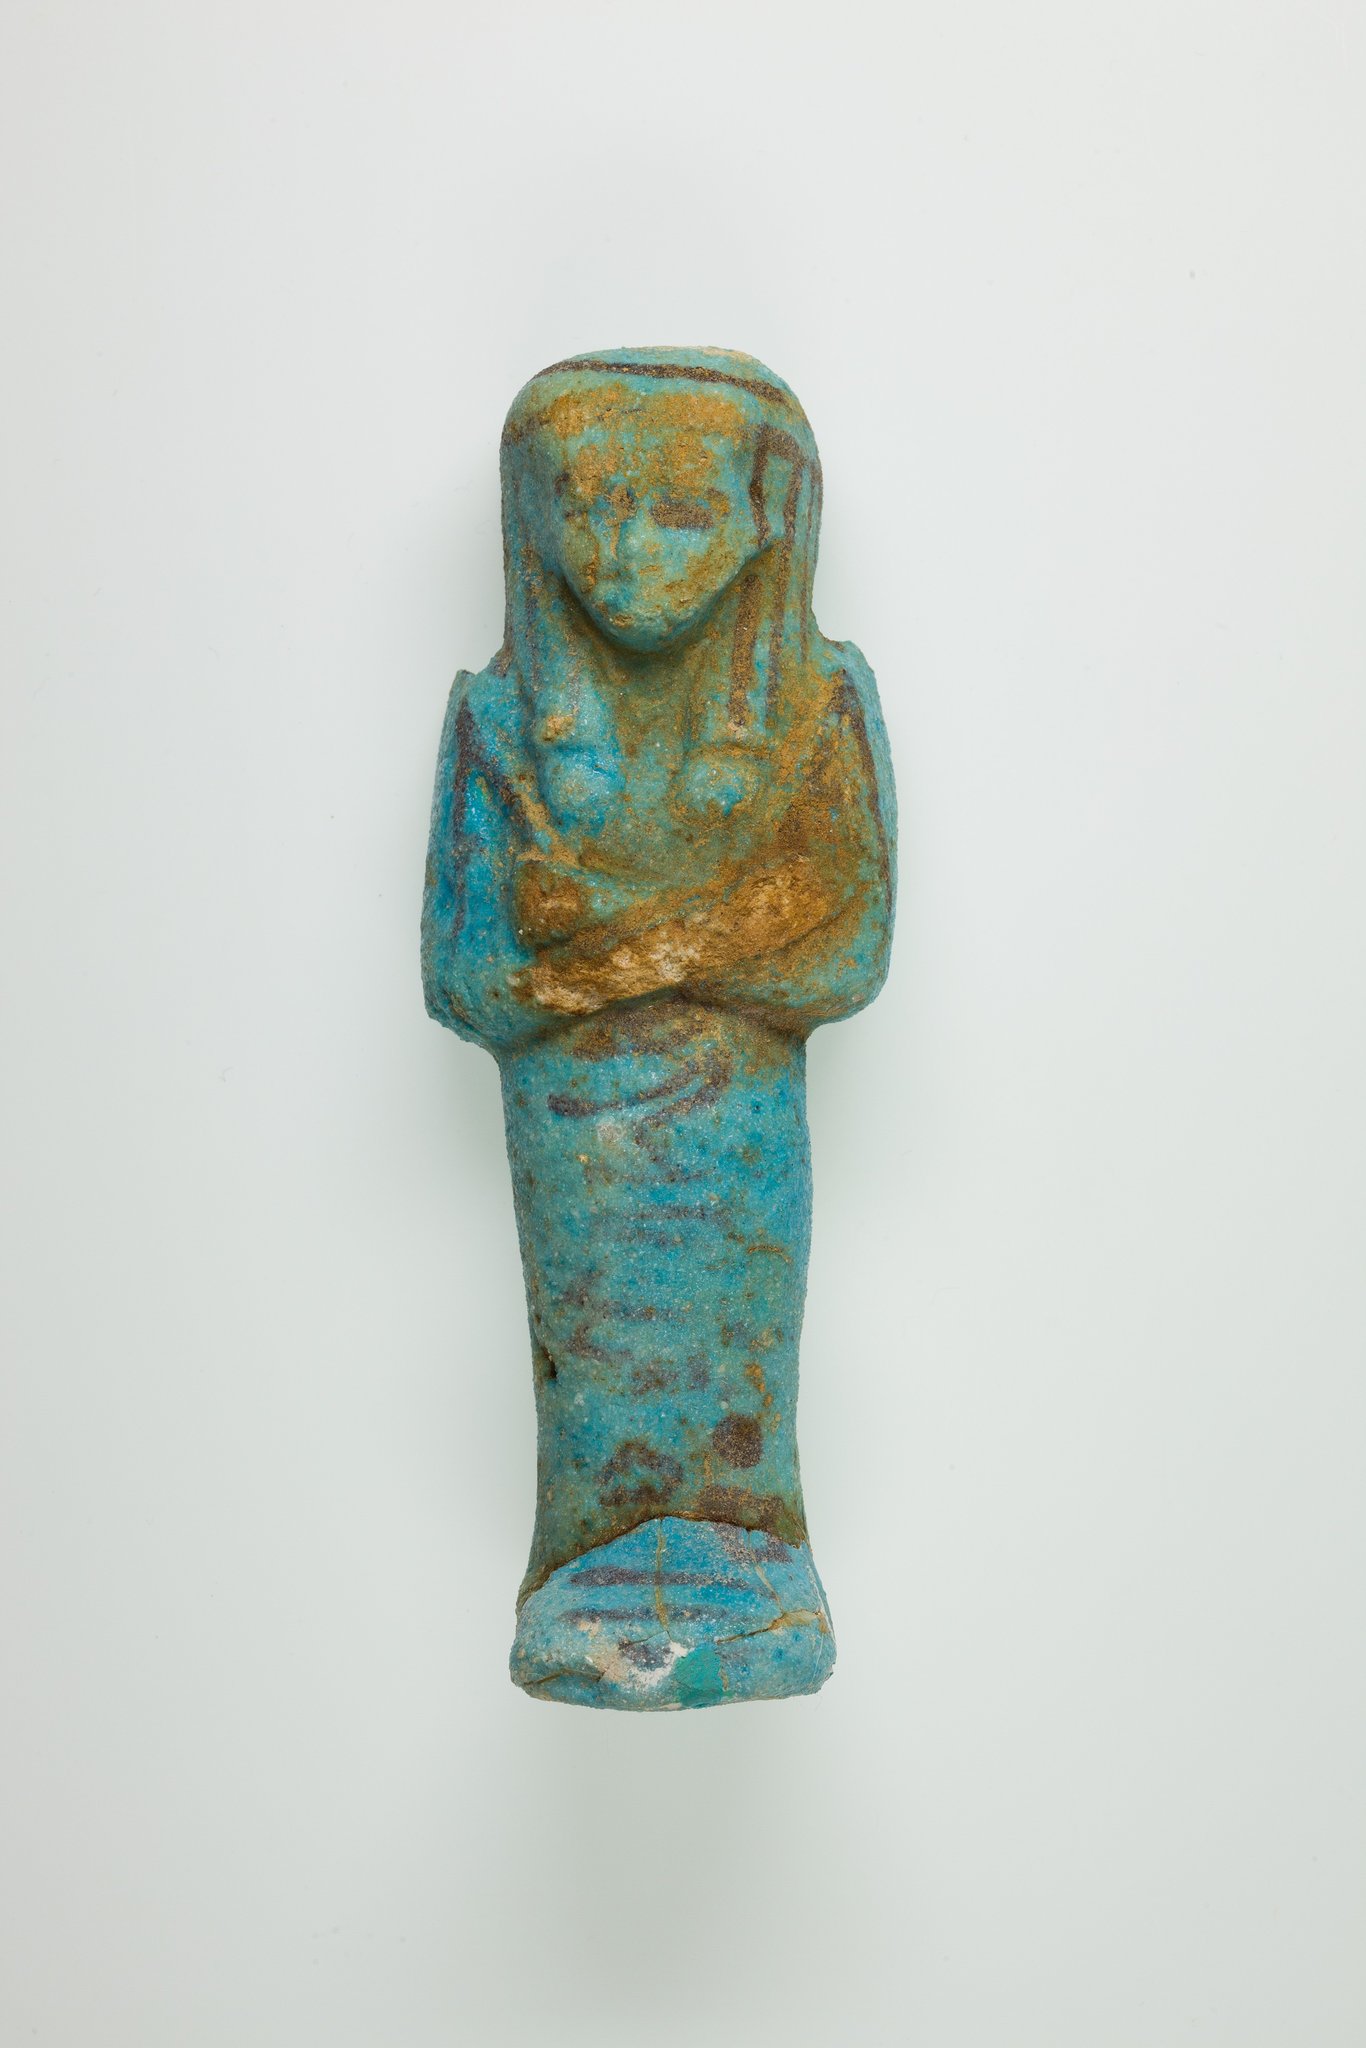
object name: shabti, henettawy c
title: Worker Shabti of Henettawy (C), Daughter of Isetemkheb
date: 990-970 BCE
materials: faience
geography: egypt